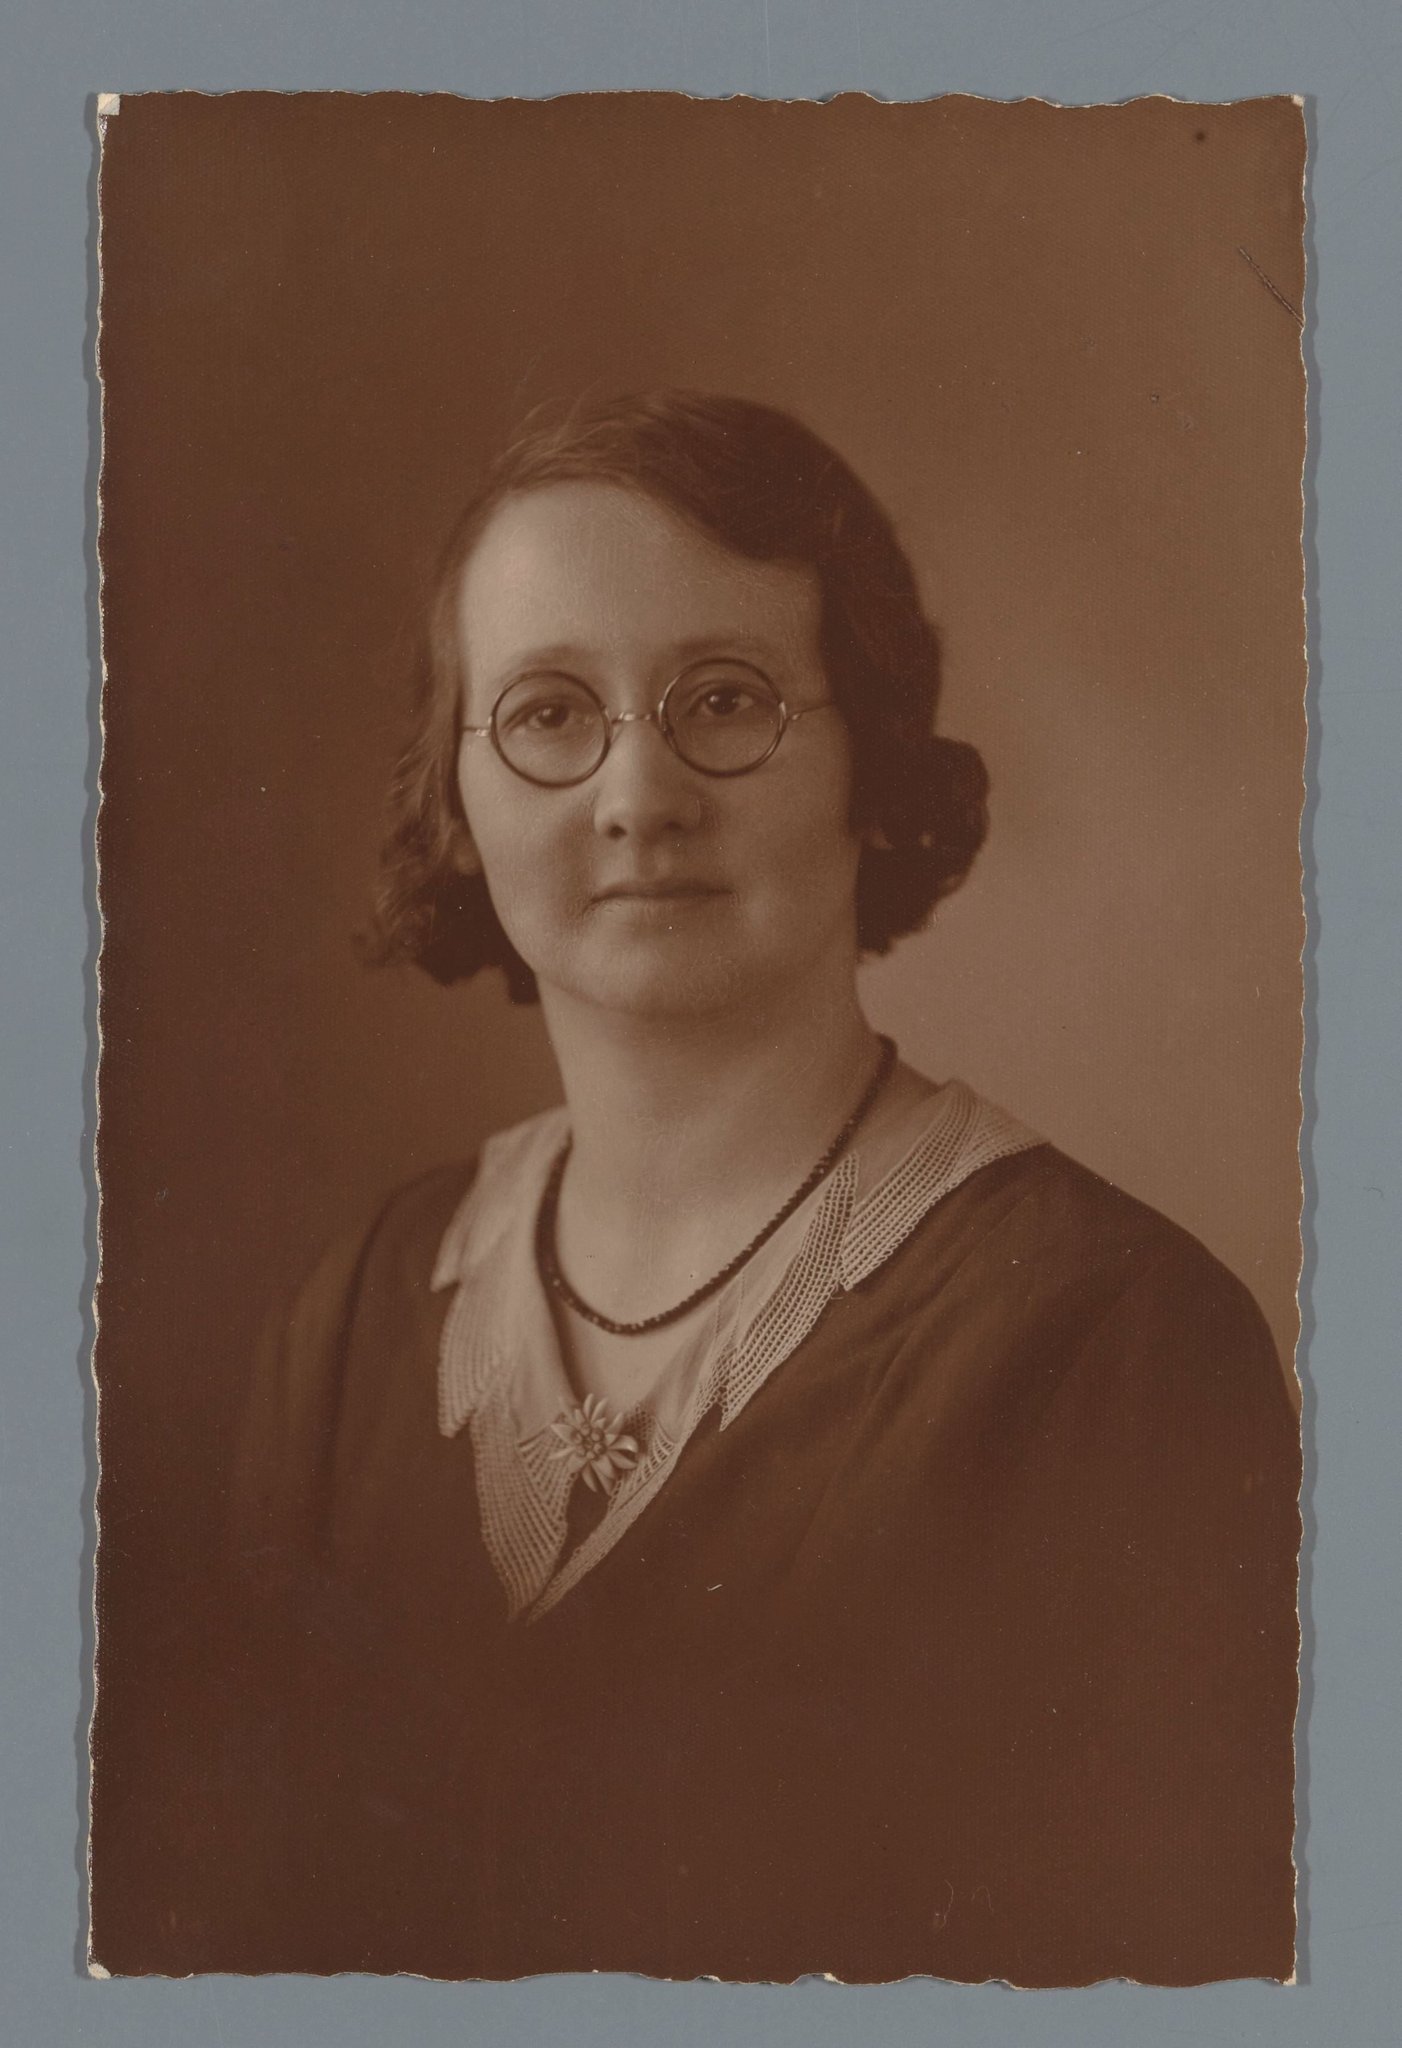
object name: photograph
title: Portret van een onbekende vrouw met een bril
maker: j. van der heide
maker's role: fotograaf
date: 1920-1935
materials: photographic support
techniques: gelatin silver print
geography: amsterdam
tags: eyeglasses, spectacles, adult woman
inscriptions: inscription: ‘J. v. d. Heide Celebesstr. 62’